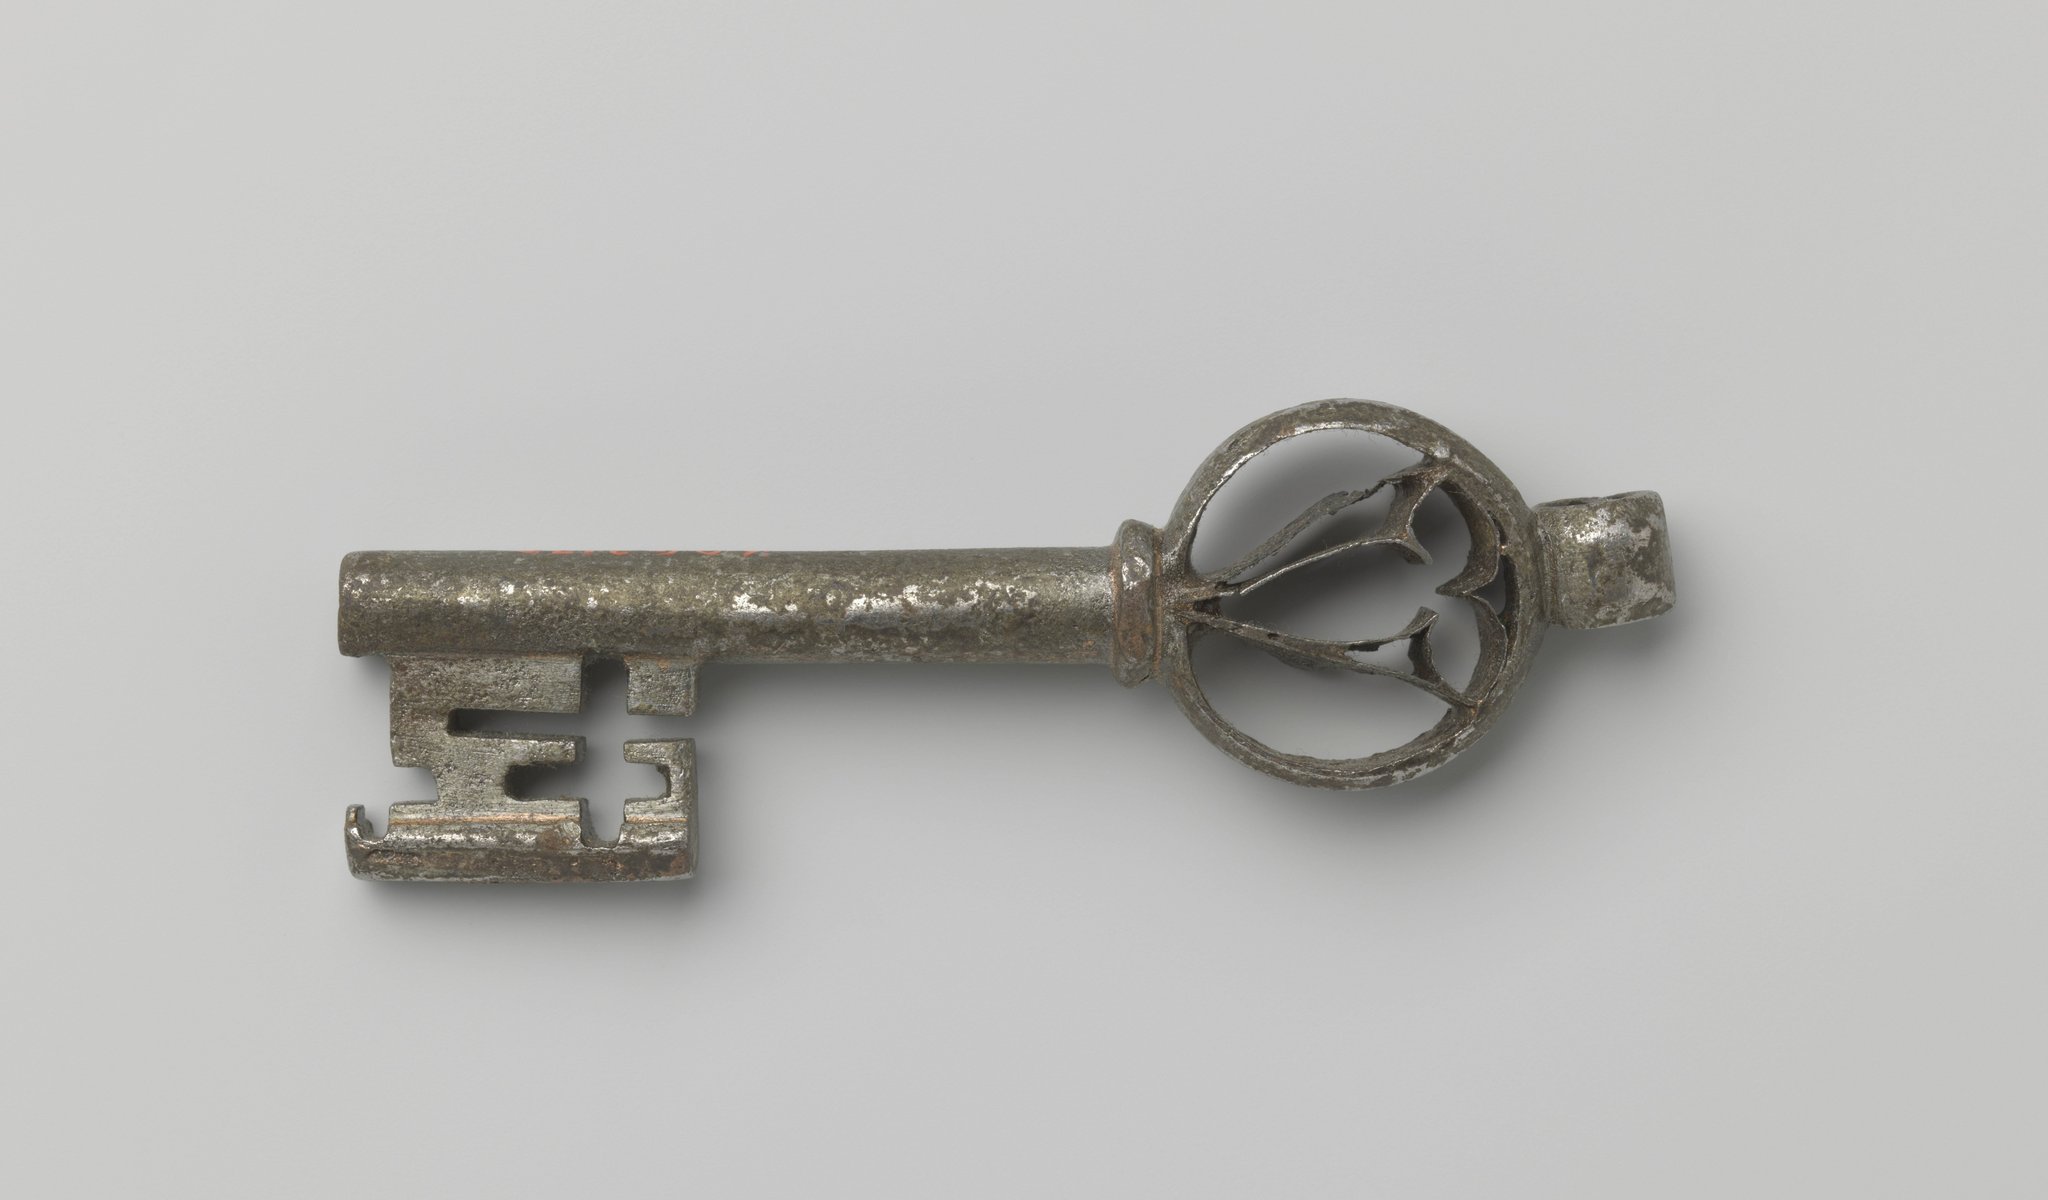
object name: pipe key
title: Pijpsleutel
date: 1500-1600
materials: iron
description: Pijpsleutel met cirkelvormige greep, gevuld met resten van traceerwerk. Hij wordt bekroond door een dwarsgesteld oog. Beschadigd.